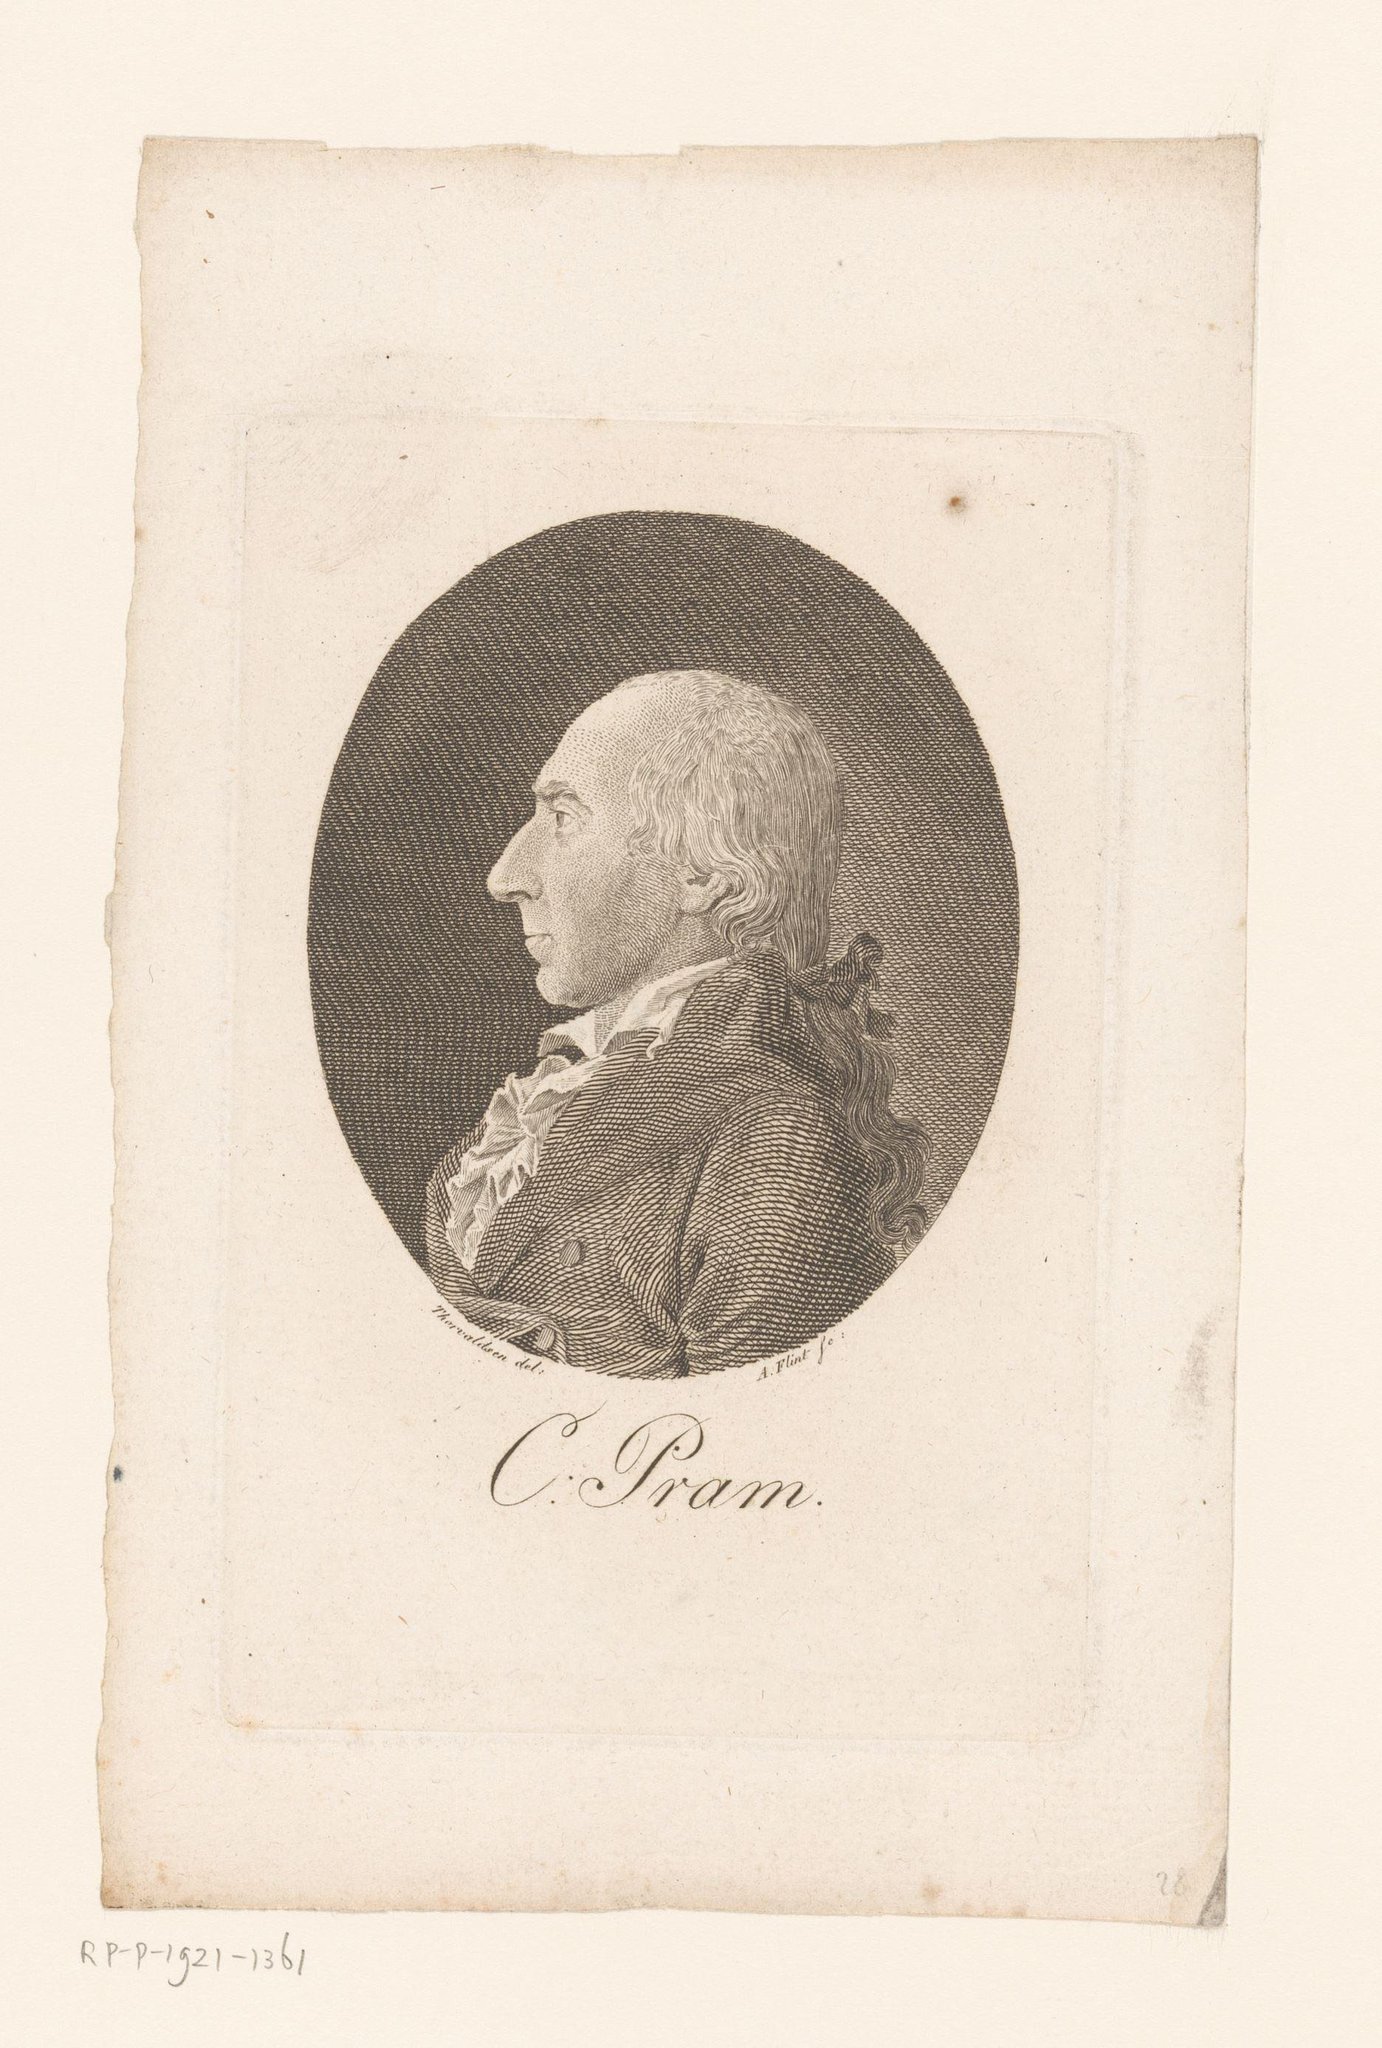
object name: print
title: Portret van Christen Pram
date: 1778-1824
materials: paper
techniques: engraving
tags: politician, historical persons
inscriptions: collector's mark: Lugt 2233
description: Portret van de Noors-Deense schrijver Christen Henriksen Pram. Buste in ovaal, profiel naar links.